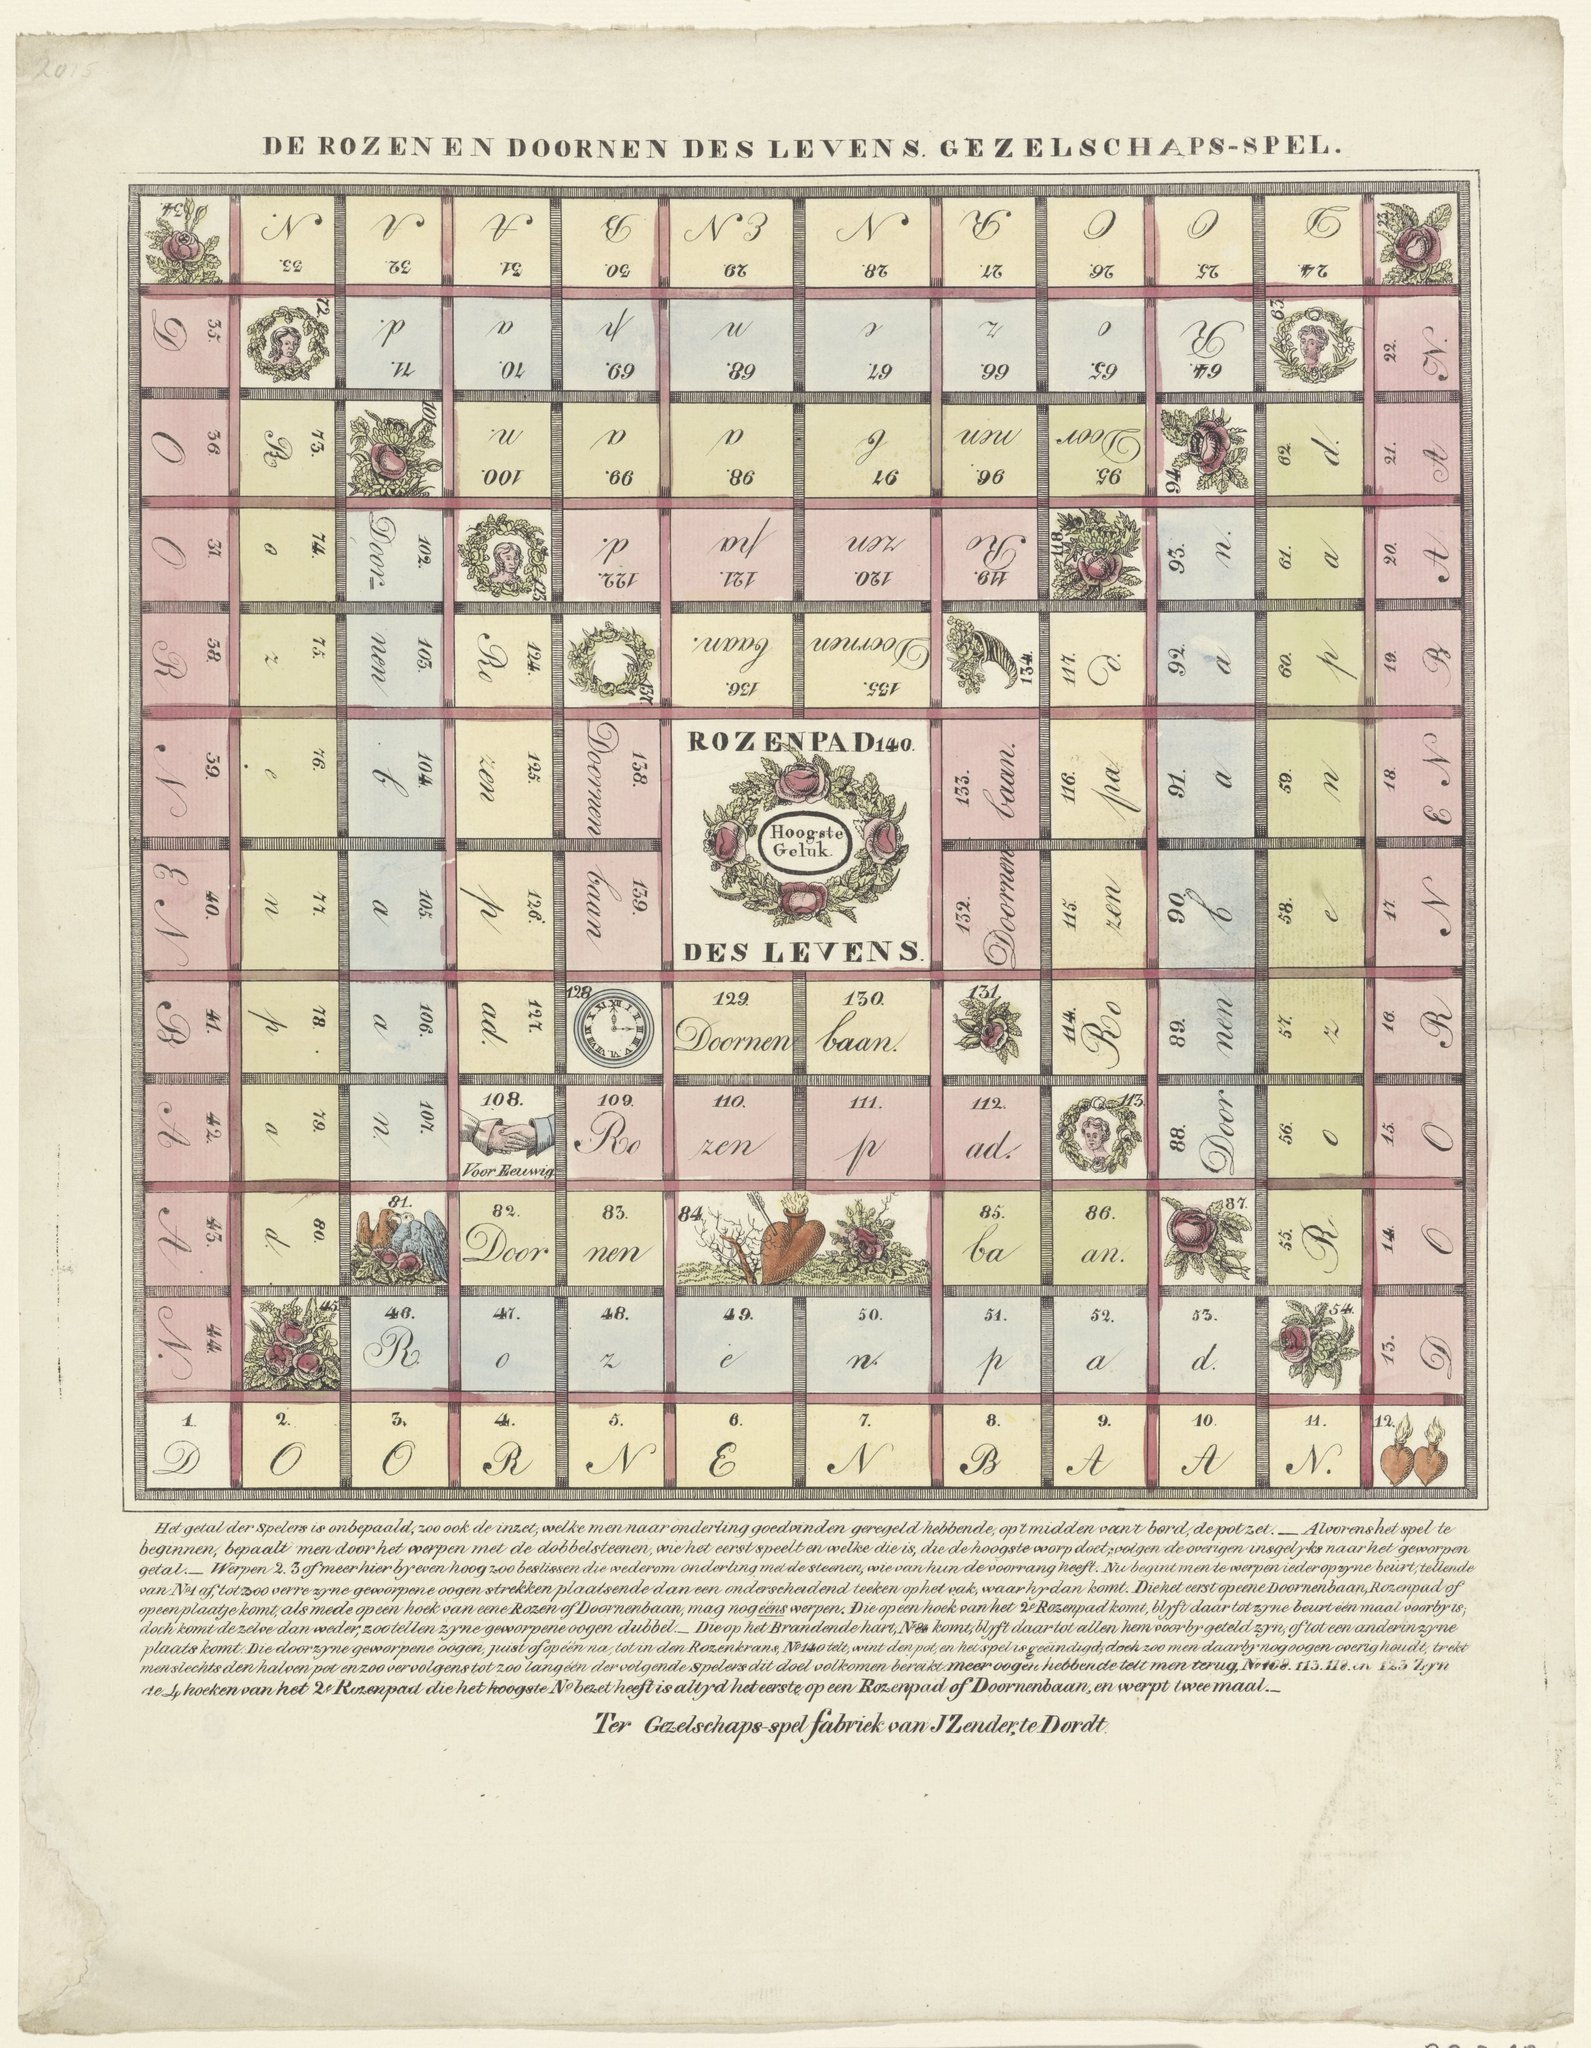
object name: popular print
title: De rozen en doornen des Levens. Gezelschaps-spel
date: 1820-1847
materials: paper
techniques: colour, lithograph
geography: dordrecht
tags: board-games of chance, flowers: rose, board-games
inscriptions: collector's mark: Lugt 2760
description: Vierkant bordspel met vakjes met nummers (1-140) en letters. Twee diagonale lijnen met bloemmotief kruisen elkaar over het hele veld. In het midden bij nummer 140 een vierkant met krans van rozen. In de ondermarge de spelregels.